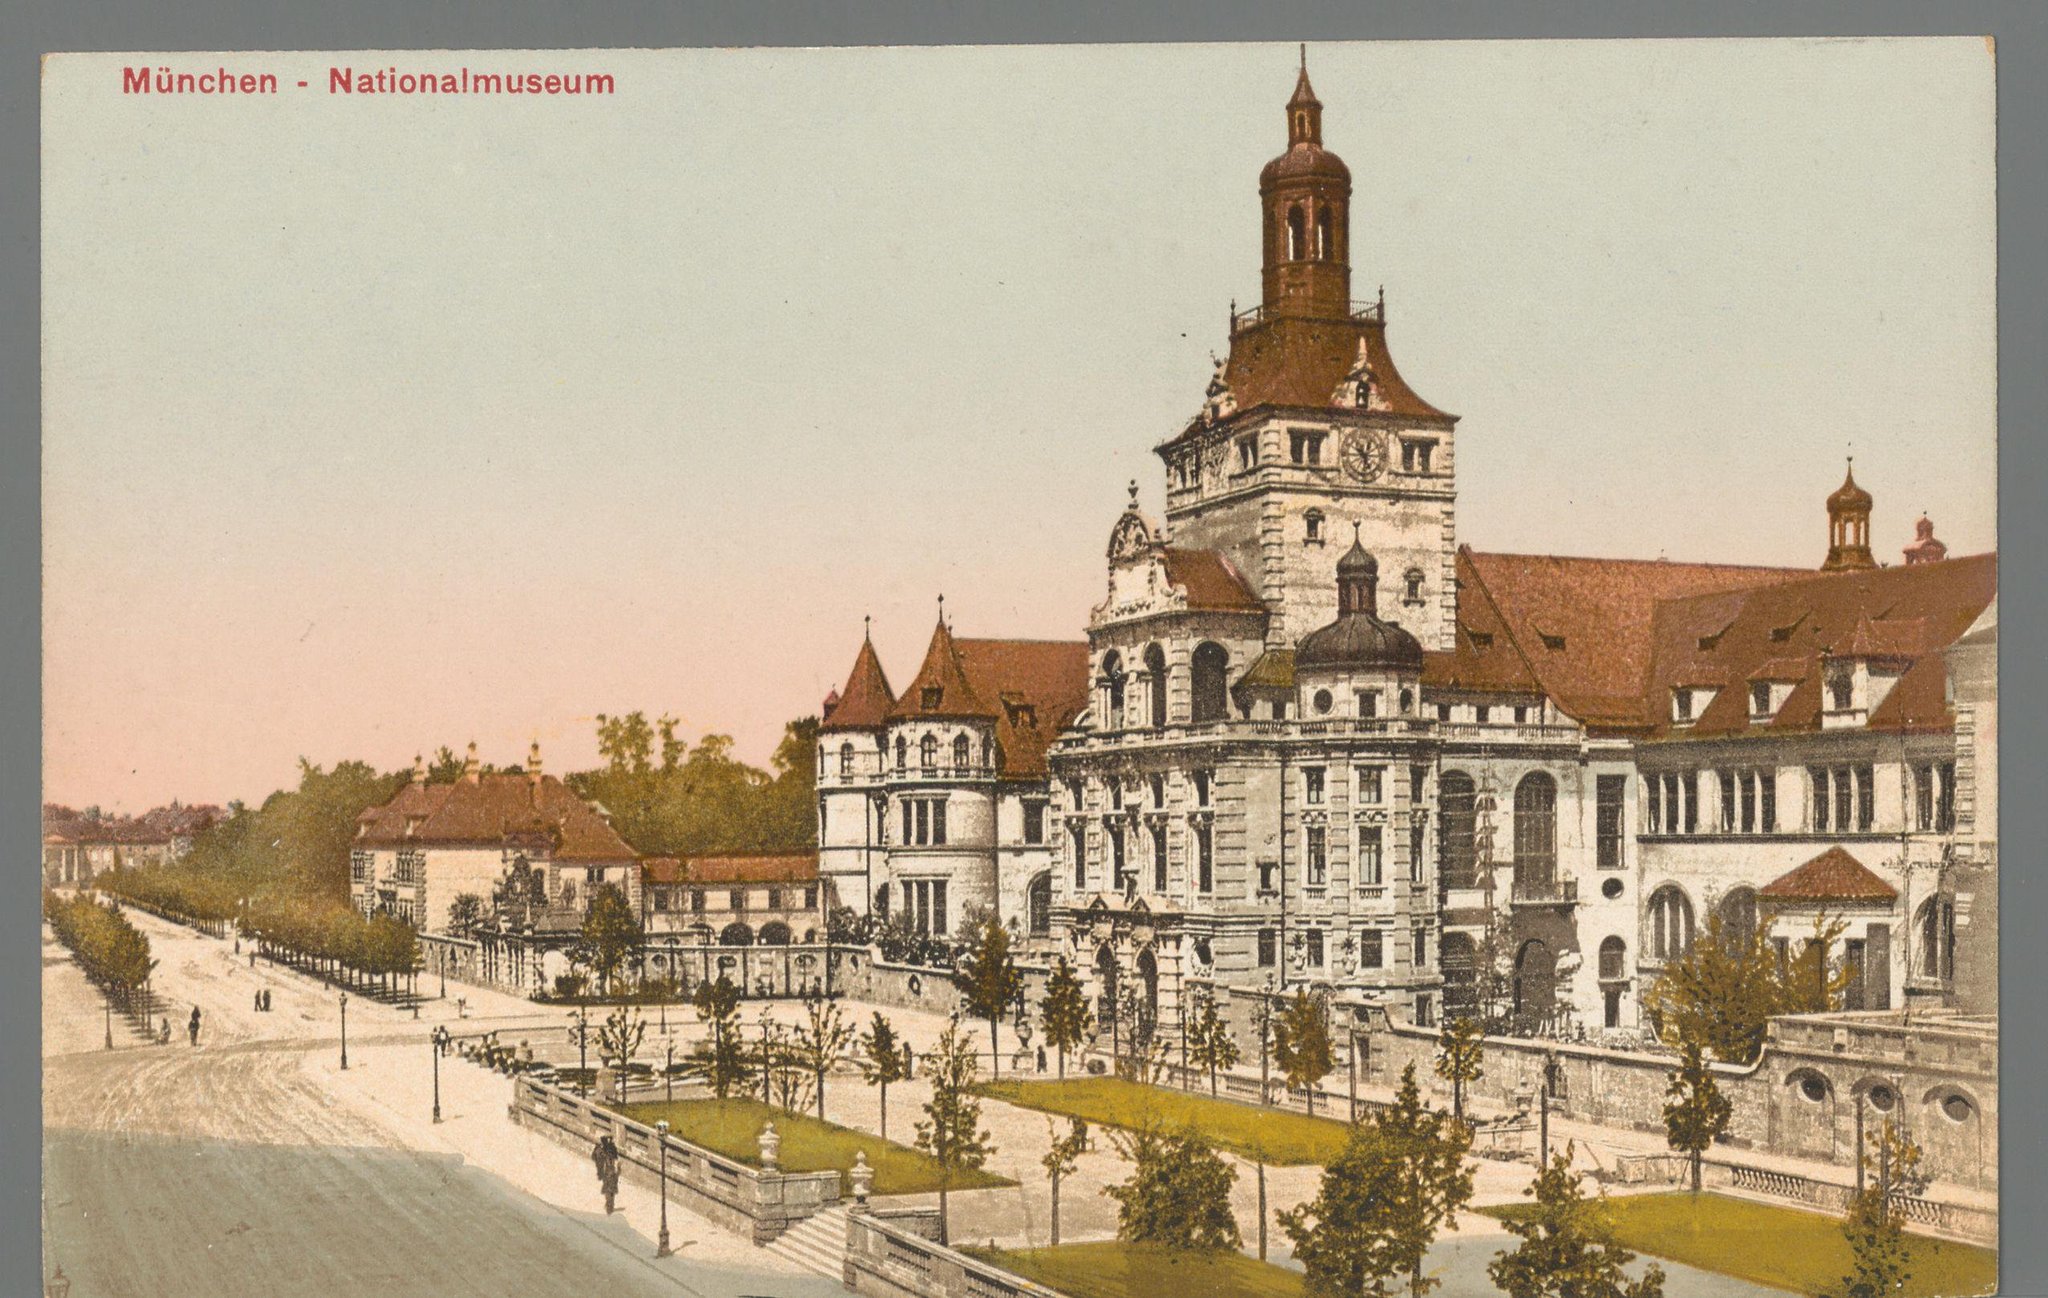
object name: print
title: München v. d. Matthäuskirche aus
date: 1905-1909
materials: cardboard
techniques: lithograph, writing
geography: munich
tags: city-view, and landscape with man-made constructions, church (exterior)